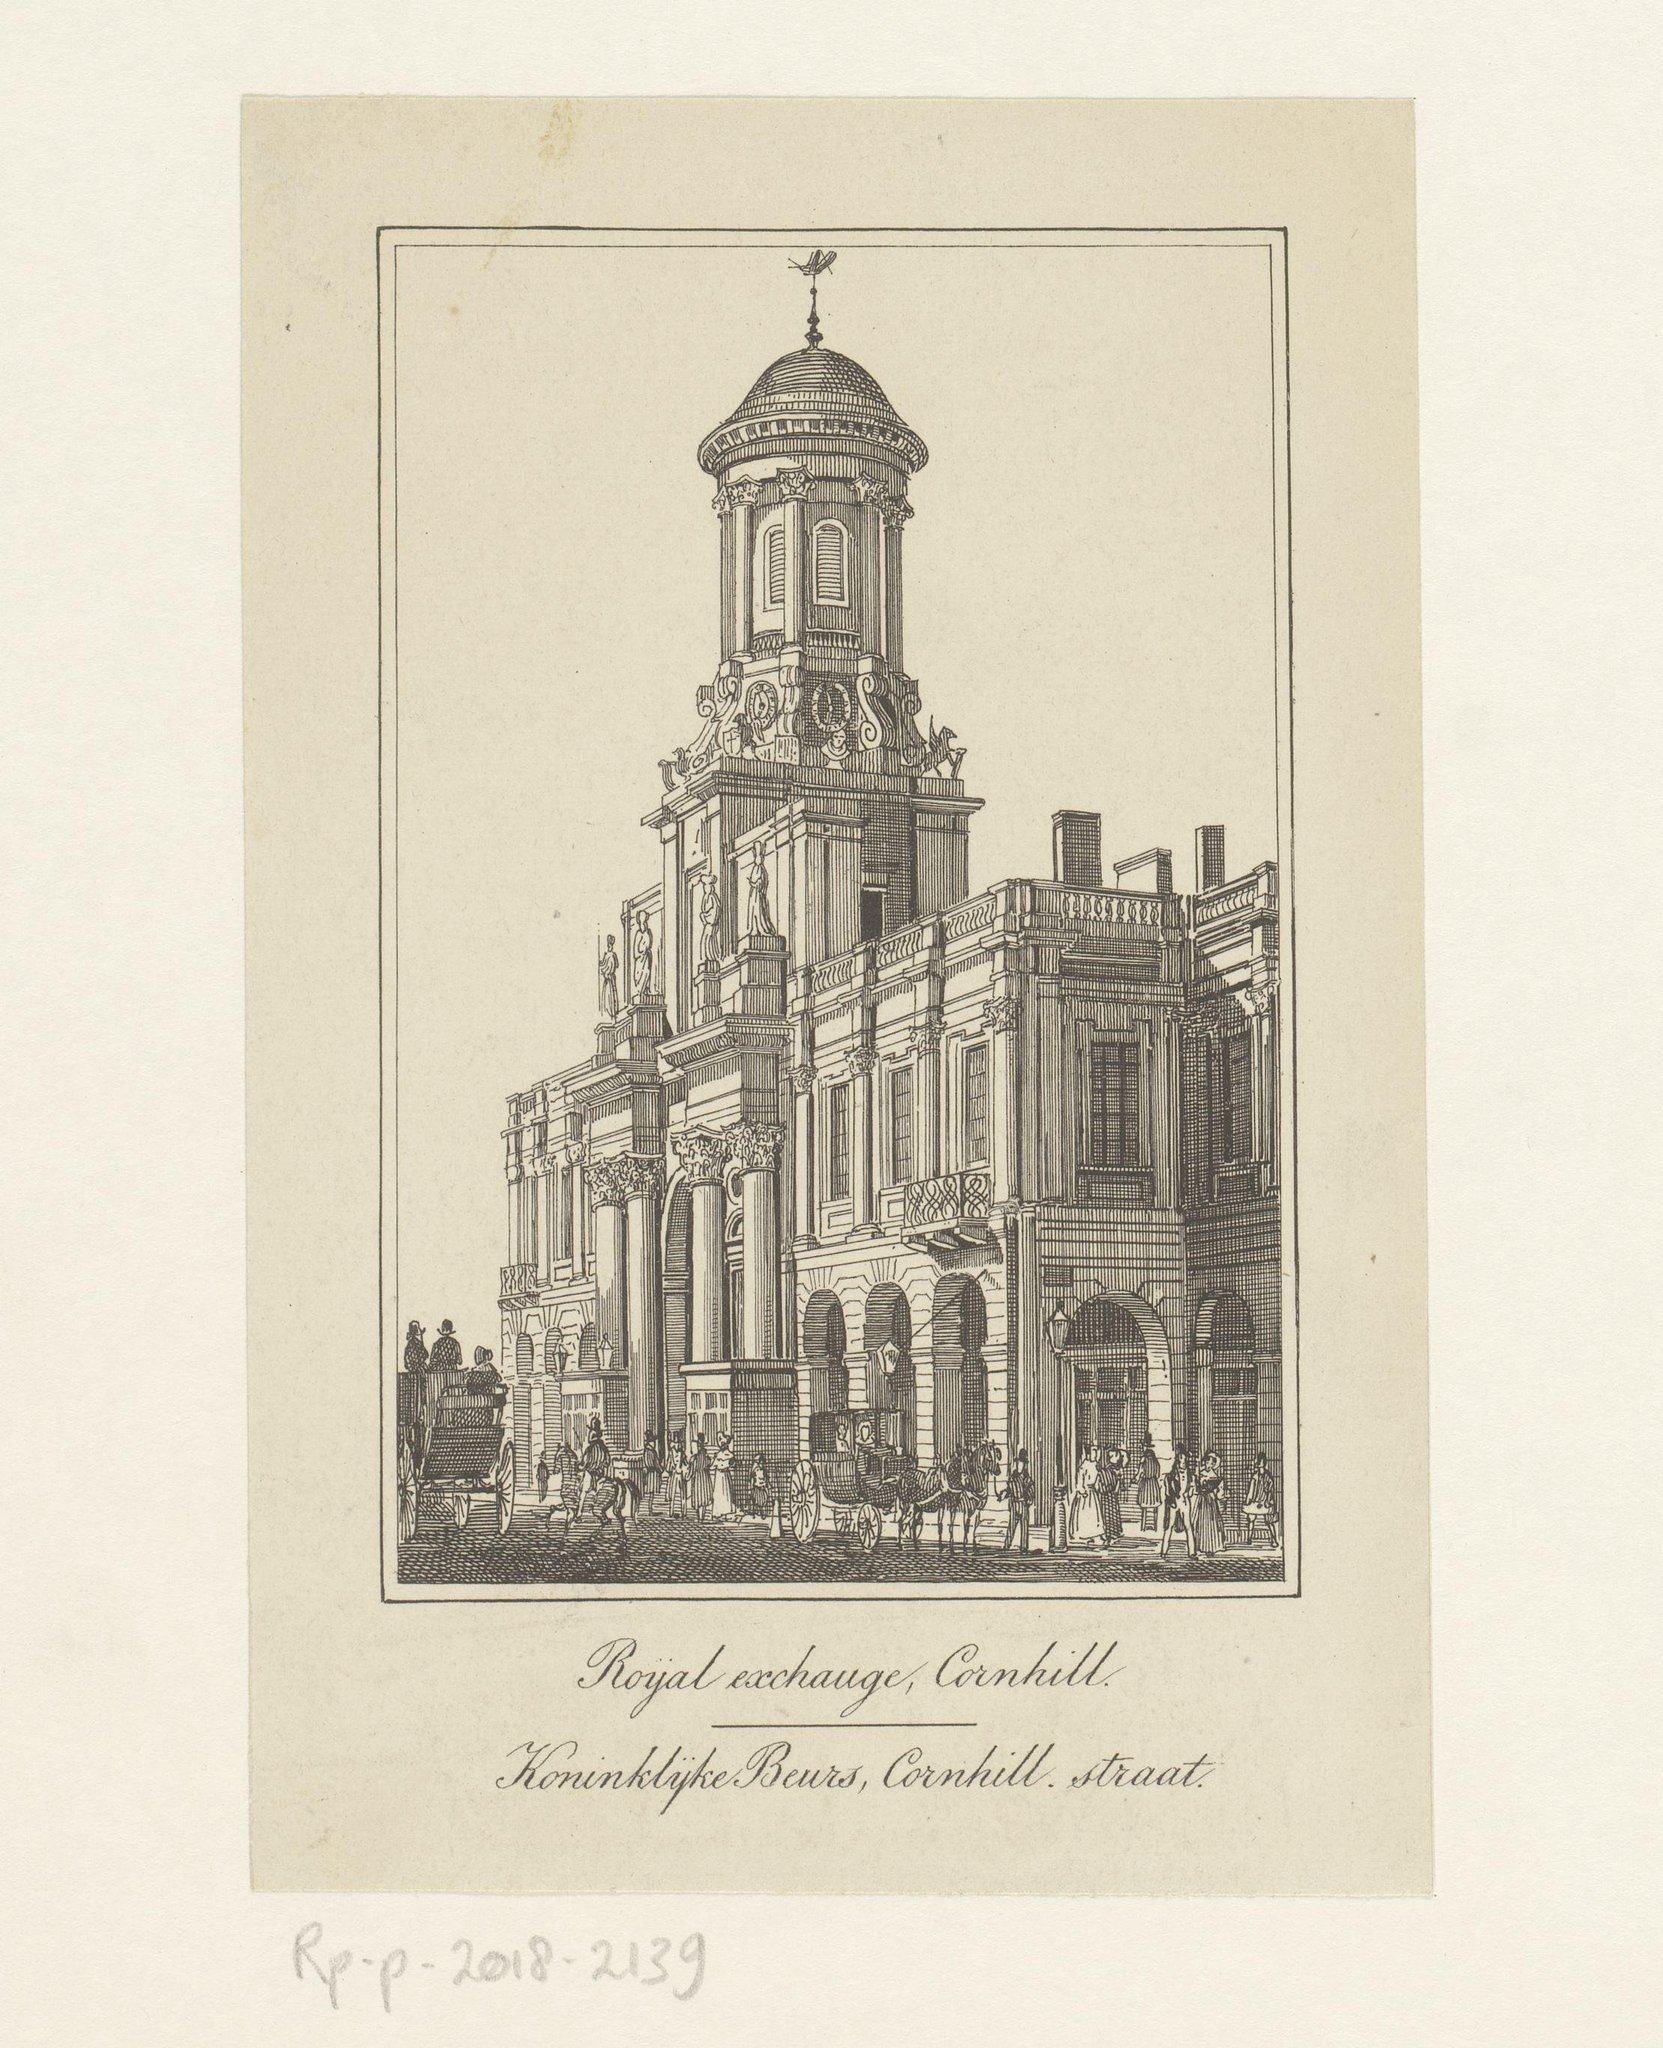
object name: print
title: Gezicht op de Royal Exchange, te Londen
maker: Anonymous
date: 1750-1849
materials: paper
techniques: etching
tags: exchange, bourse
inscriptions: collector's mark: Lugt 2228